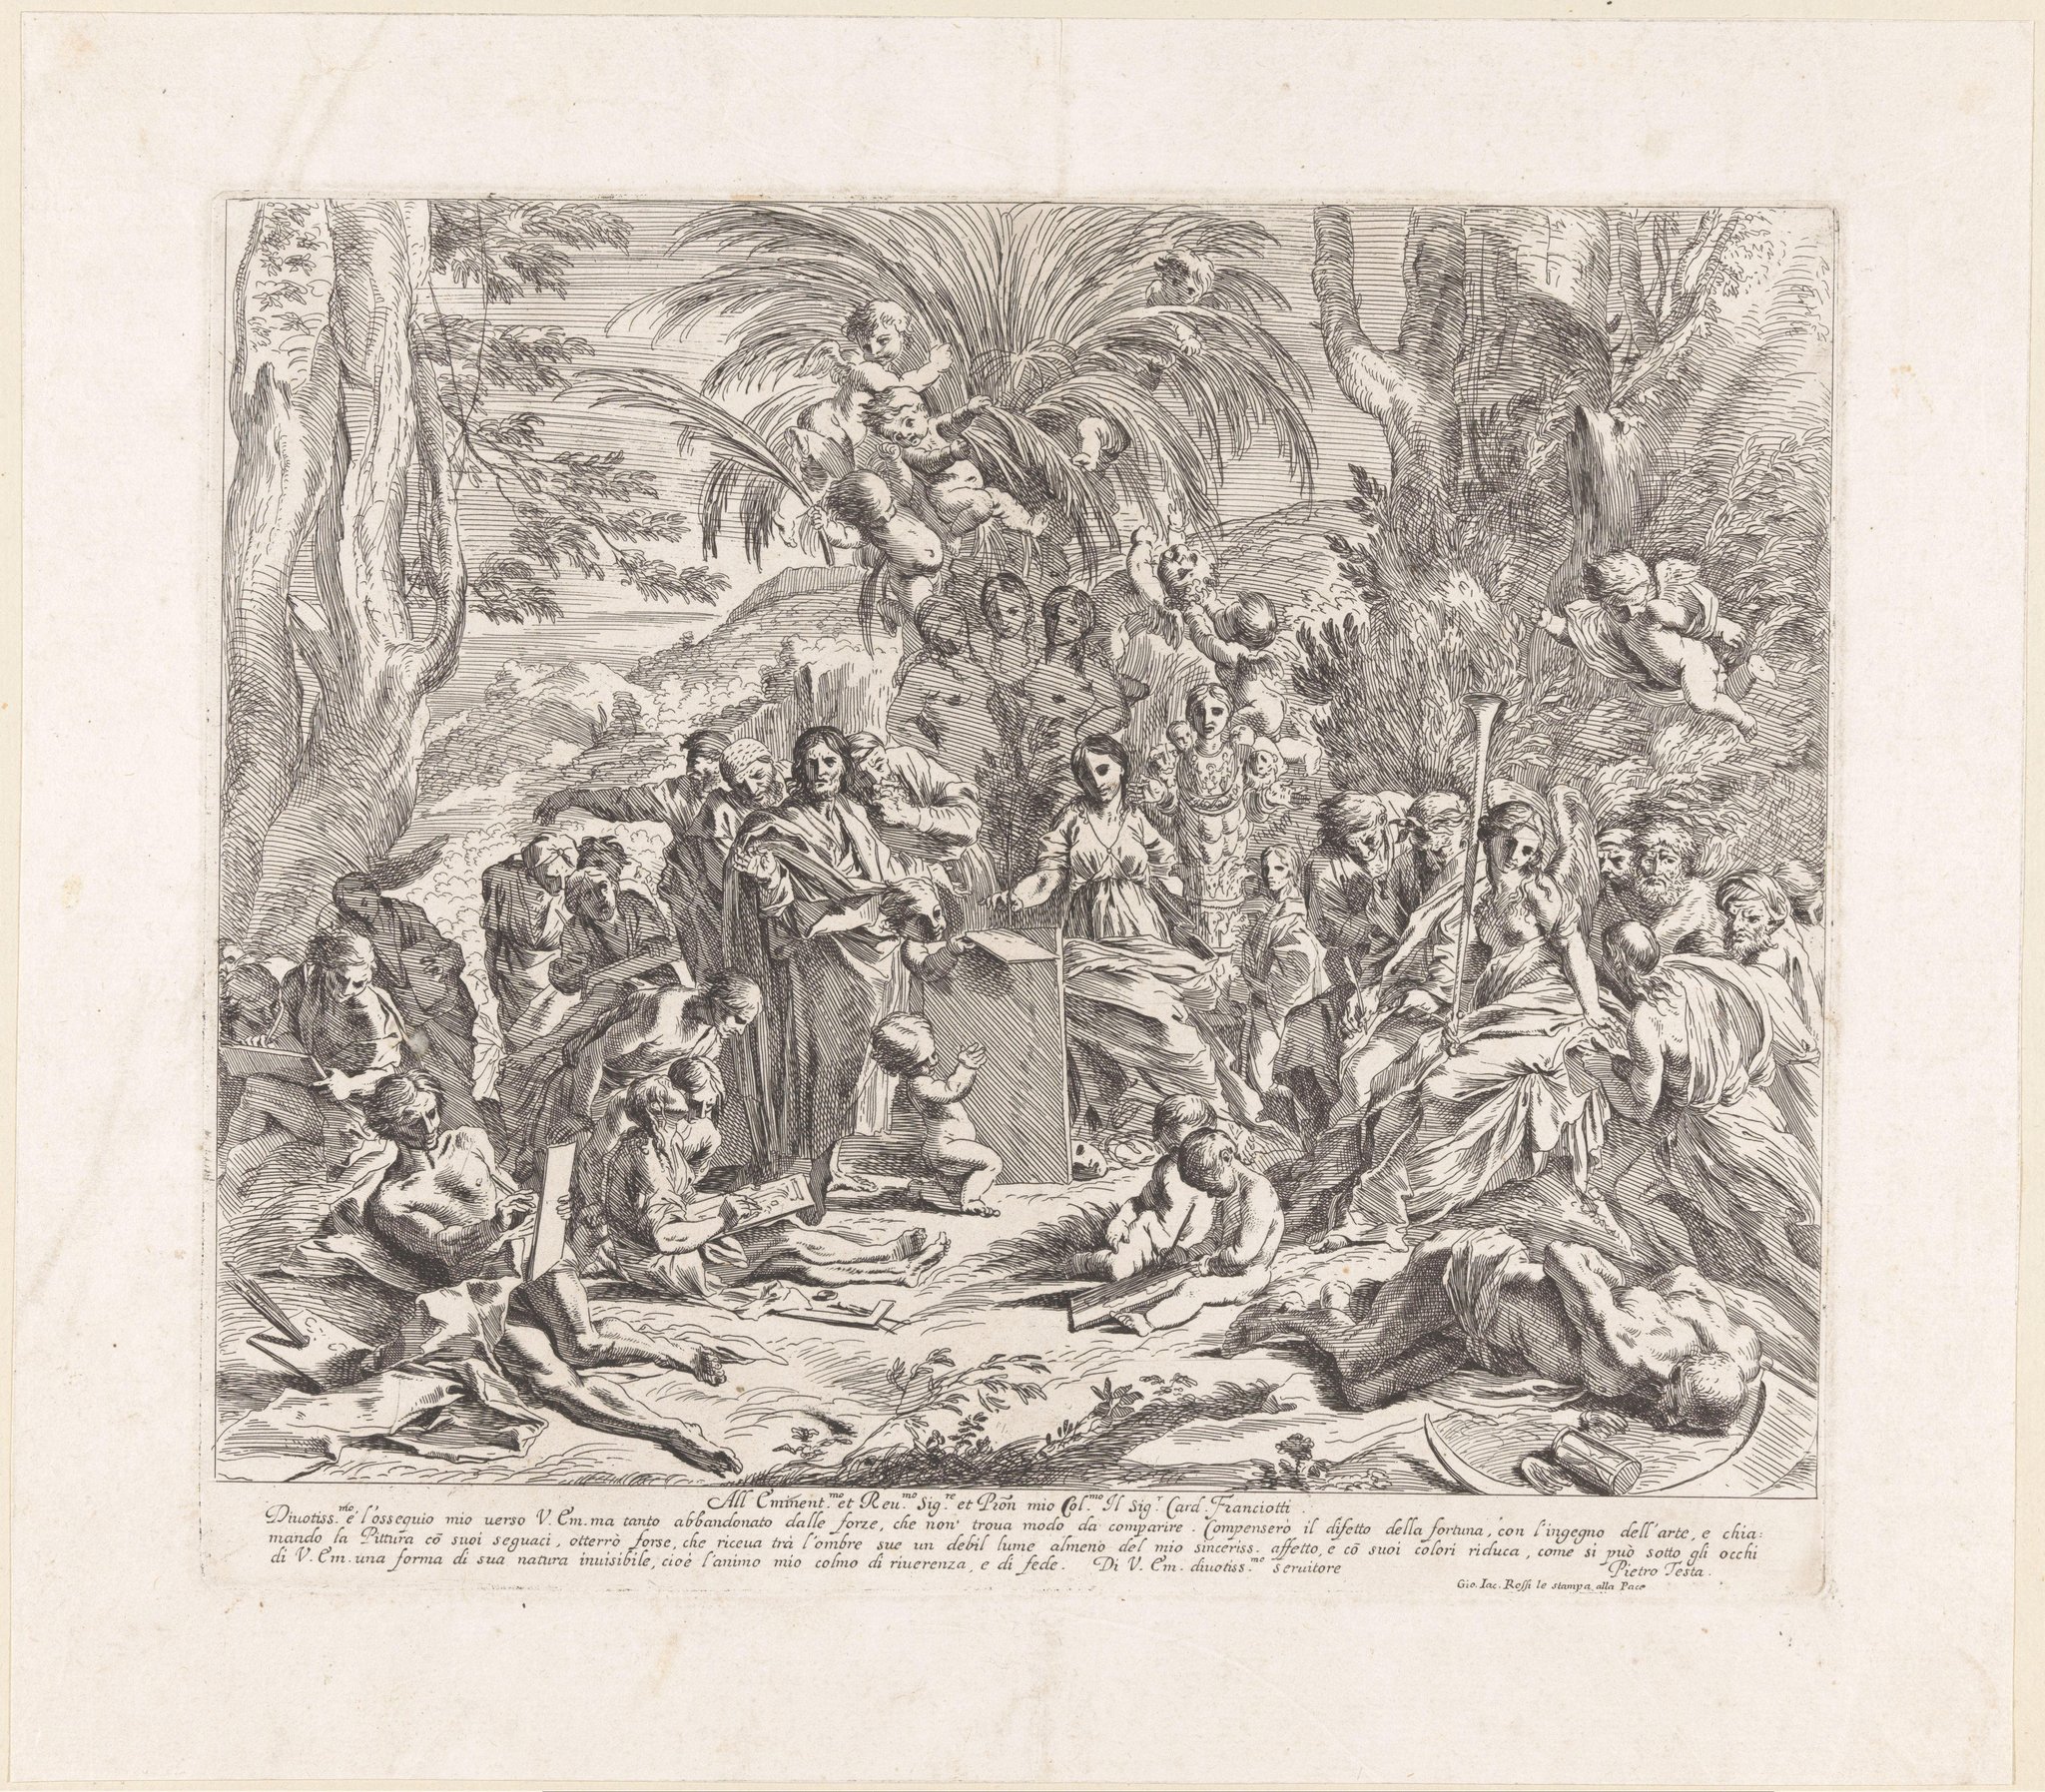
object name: print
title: Personificatie van schilderkunst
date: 1637-1638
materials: paper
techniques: etching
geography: italy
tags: 'pictura', symbolic representations, allegories and emblems ~ painting; 'pittura' (ripa), draughtsman at work, trees: palm-tree, fame; 'fama', 'fama buona', 'fama chiara' (ripa), father time, man with wings and scythe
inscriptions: collector's mark: Lugt 240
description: In het midden een personificatie van schilderkunst. Naast haar een sculptuur van Artemis van Efeze. Rechts personificaties van Faam en Tijd. In het midden op de achtergrond de drie gratiën en een palmboom. Links tekenende kinderen en jongelingen. Opdracht in ondermarge.